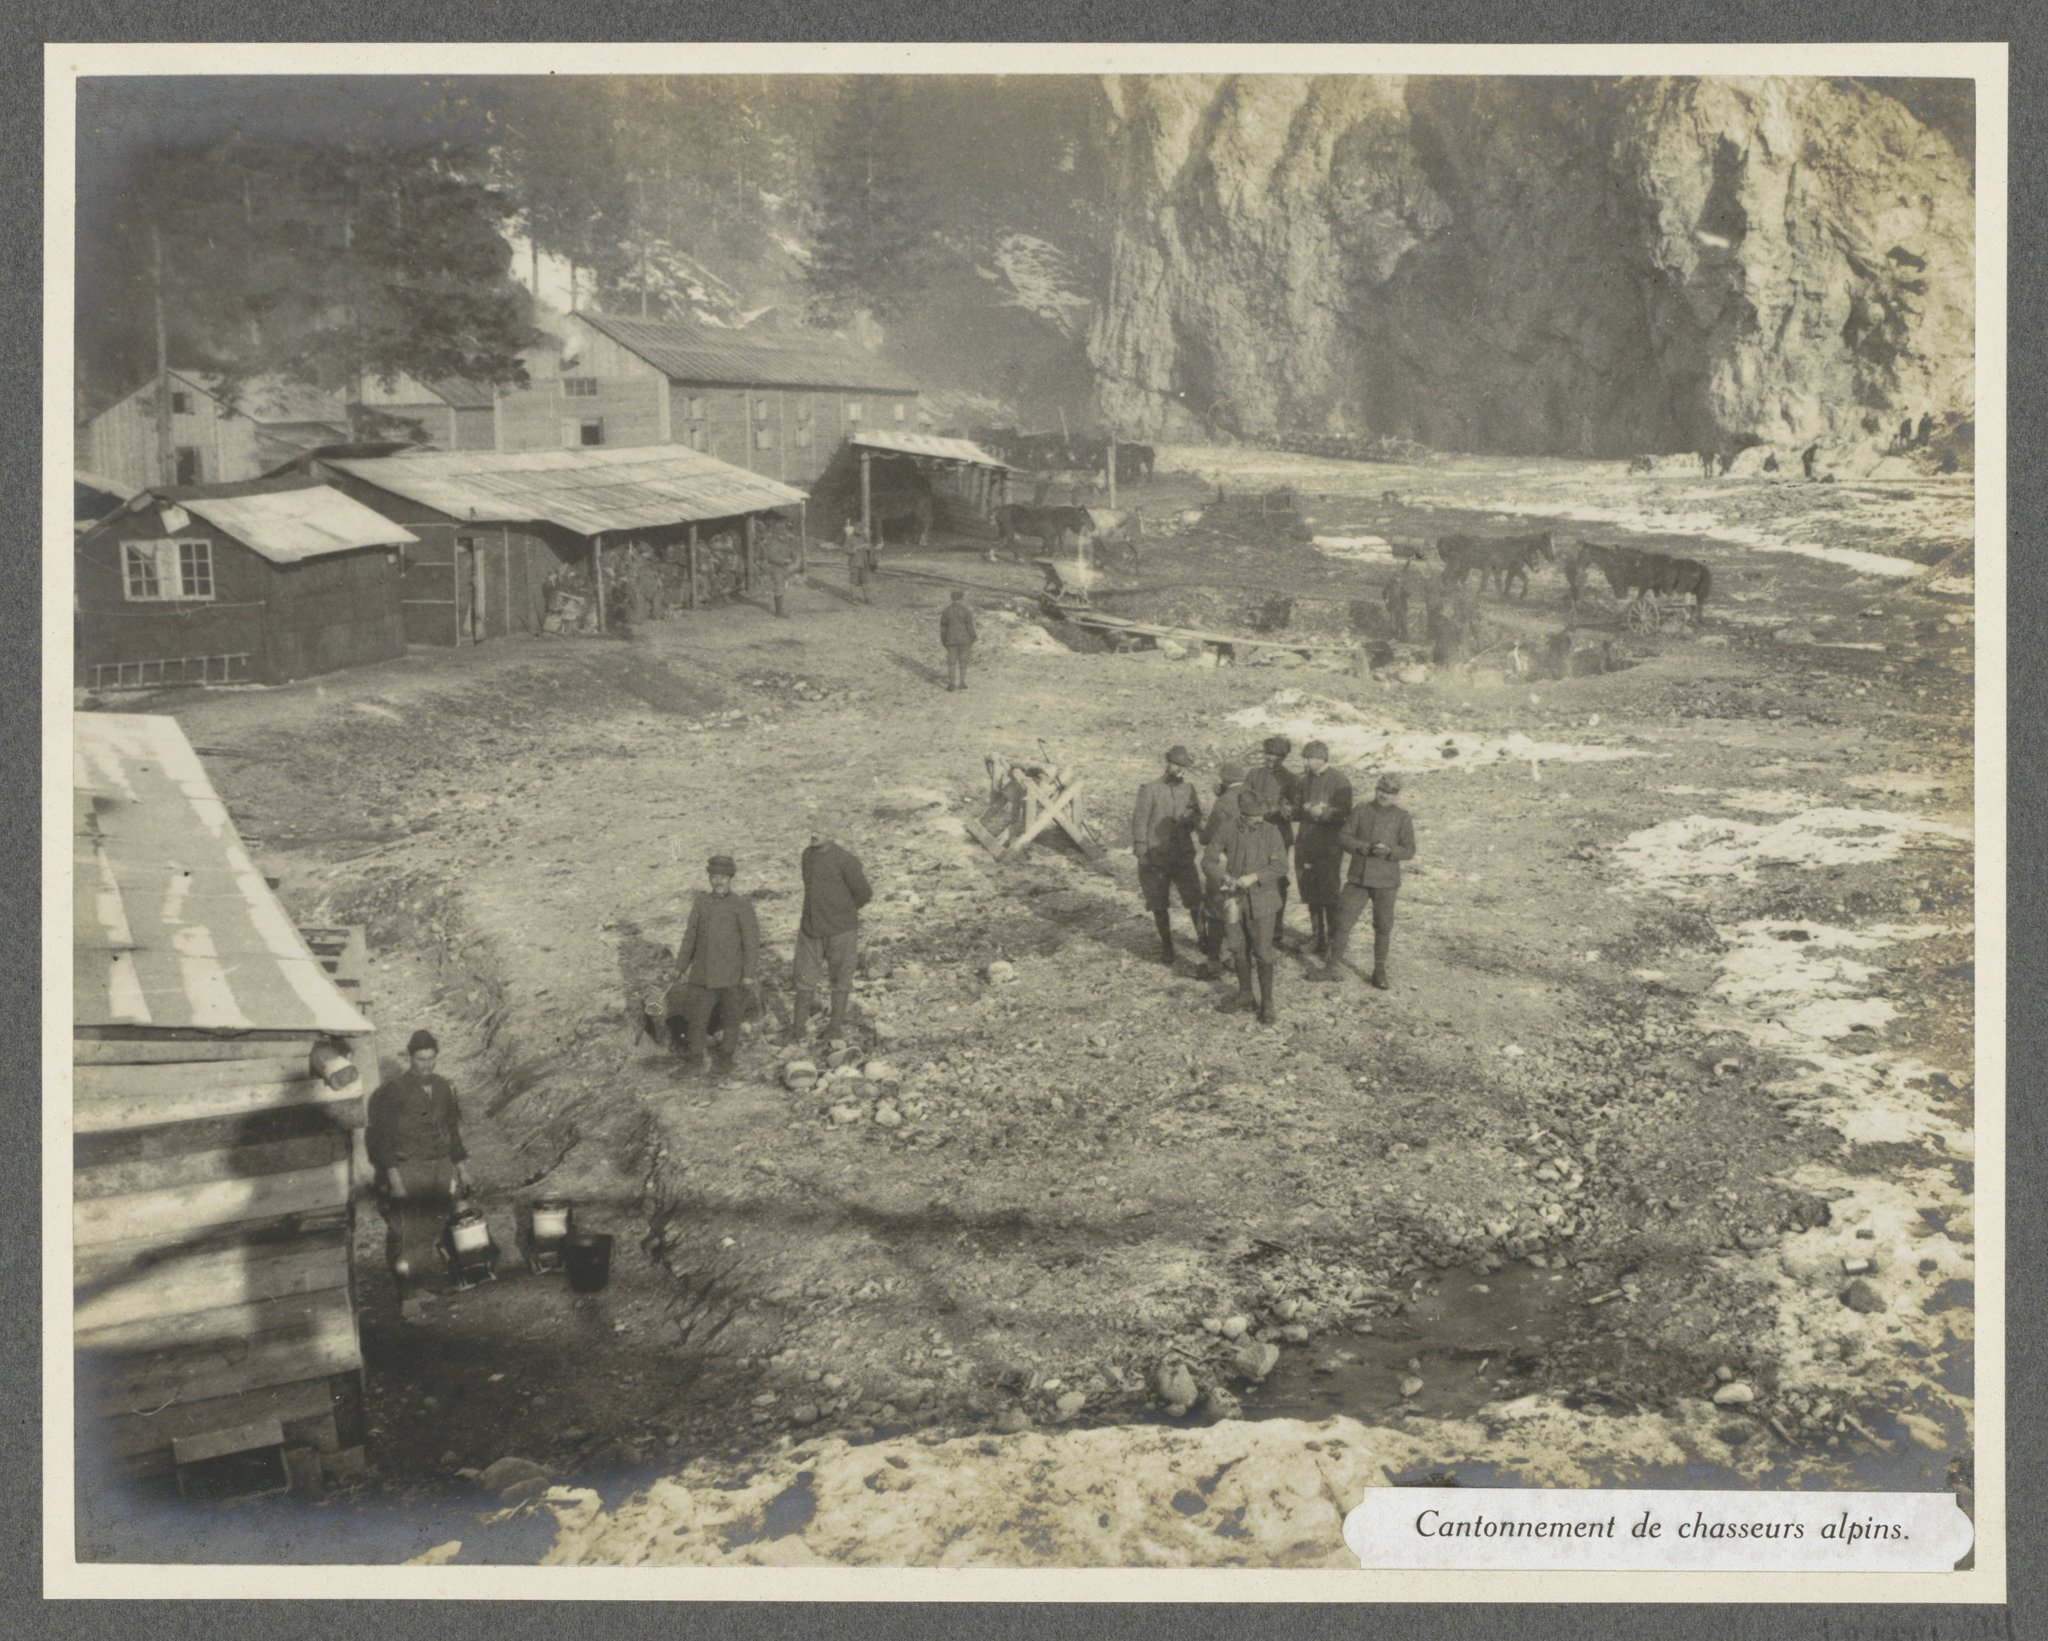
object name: photograph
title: Legerkamp van Alpenjagers in de Dolomieten, vermoedelijk Italianen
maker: henri de rothschild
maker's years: 1872-1947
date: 1916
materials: photographic support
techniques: gelatin silver print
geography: dolomites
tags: war (+ land forces), (military) camp with tents (+ warfare in mountainous area)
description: Onderdeel van Fotoalbum Medische missie H. de Rothschild naar het Italiaanse front 1916.